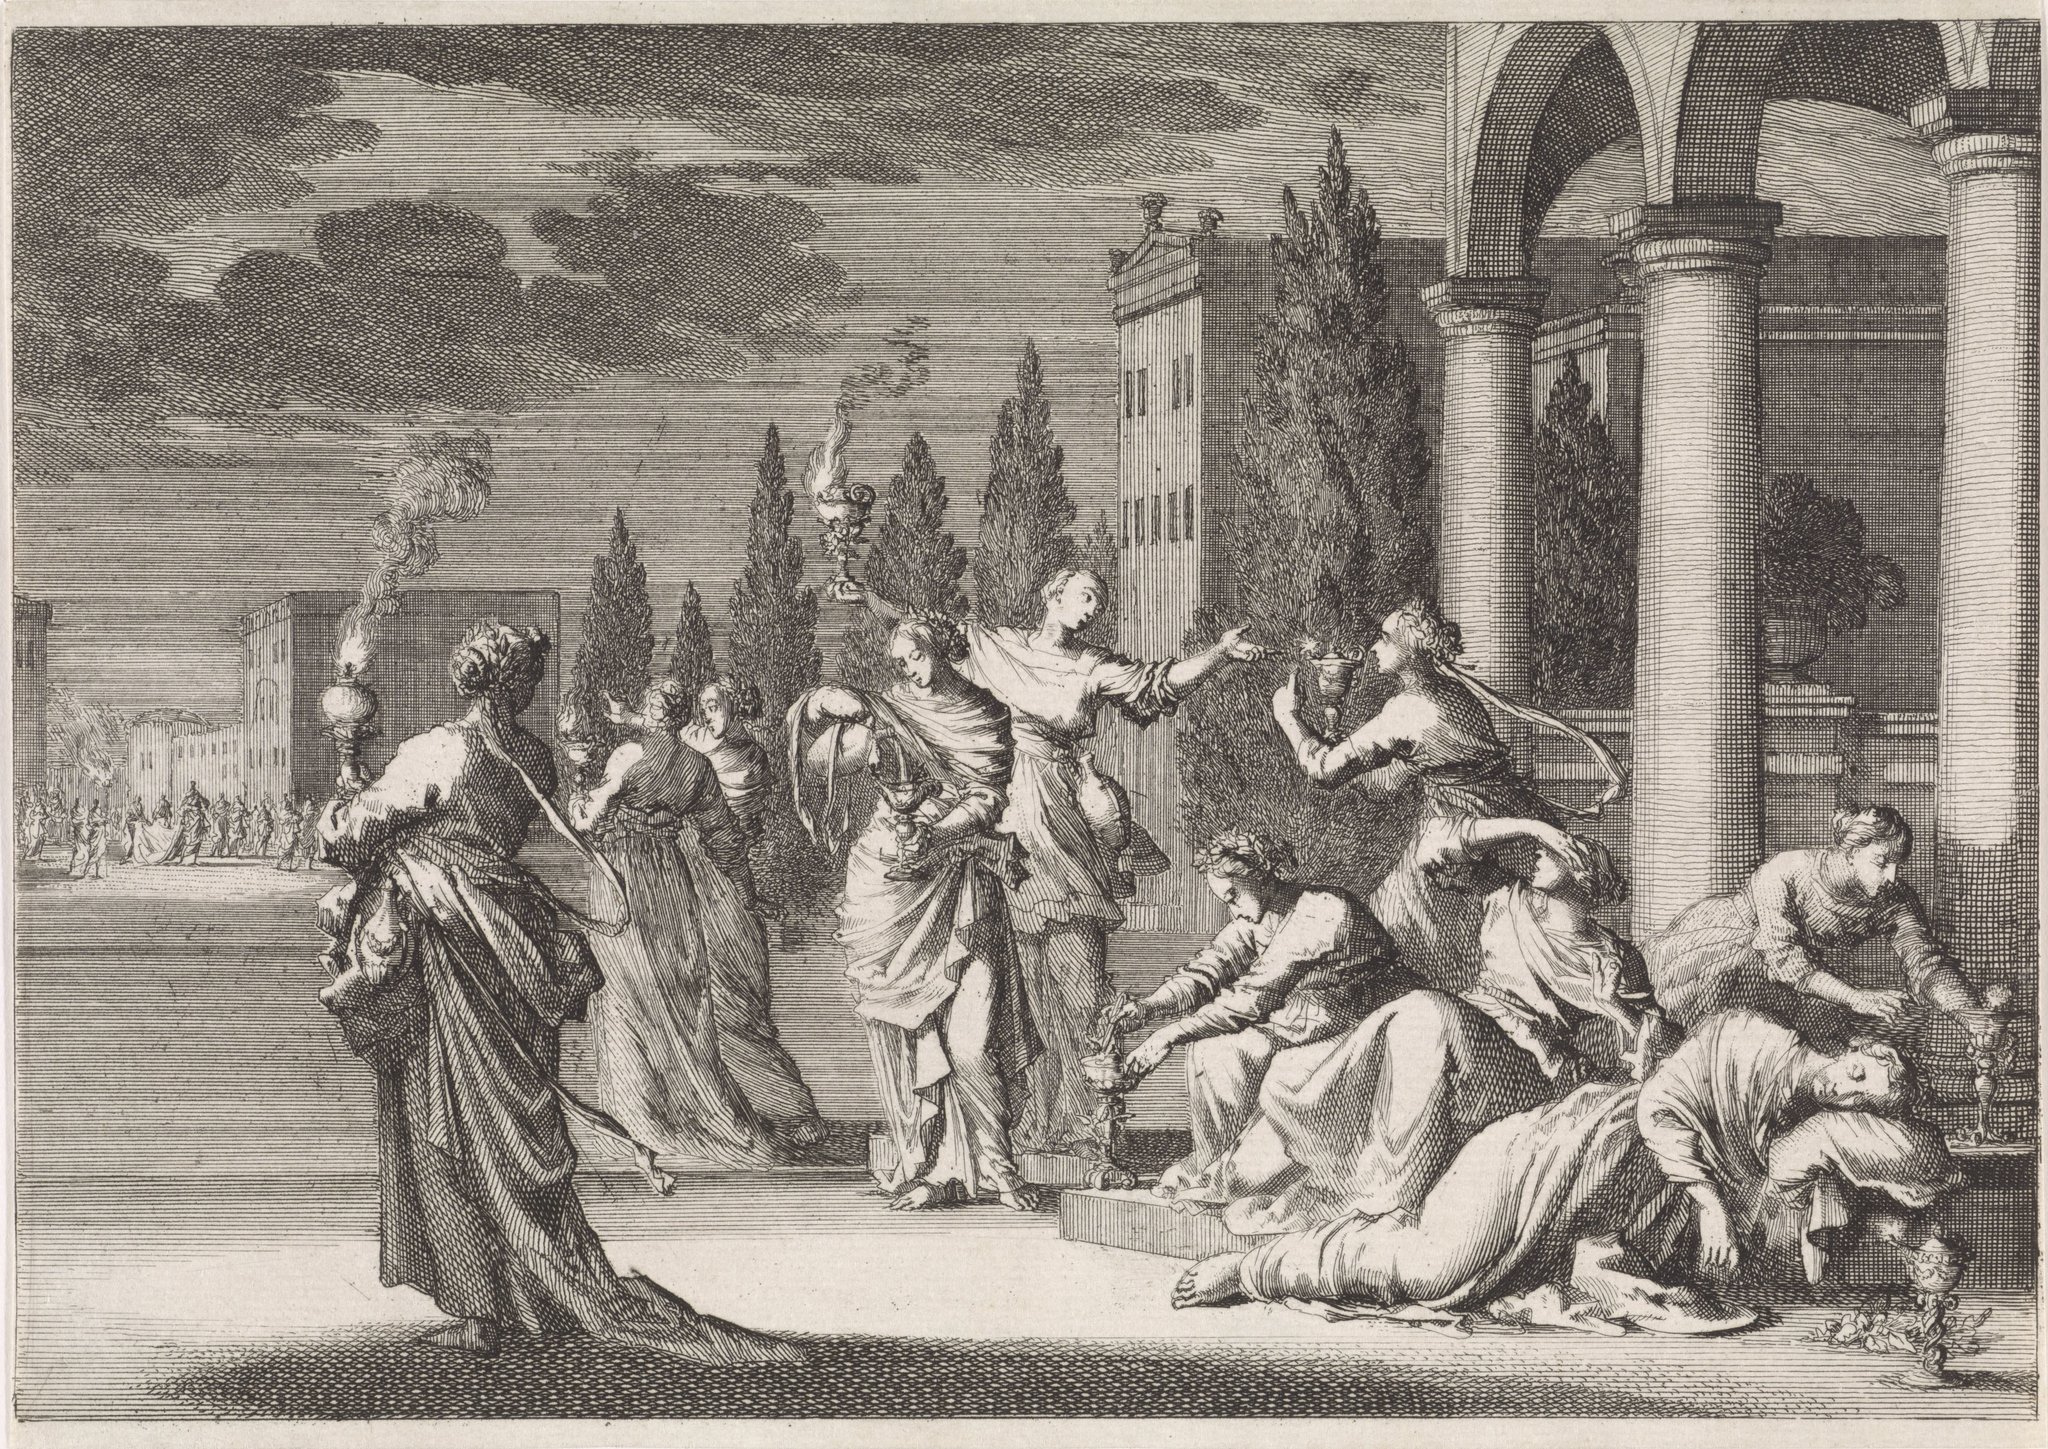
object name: print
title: Gelijkenis van de vijf wijze en de vijf dwaze maagden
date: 1700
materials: paper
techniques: etching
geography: amsterdam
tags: when the bridegroom arrives, all wake up and the foolish virgins ask the wise virgins oil for their lamps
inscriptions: collector's mark: Lugt 2228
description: Op de voorgrond de vijf wijze en de vijf dwaze maagden. De vijf wijze maagden hebben hun olielampen aangestoken en wandelen richting de bruidegom op de achtergrond. De vijf dwaze maagden liggen te slapen of proberen hun lege olielampen aan te steken.